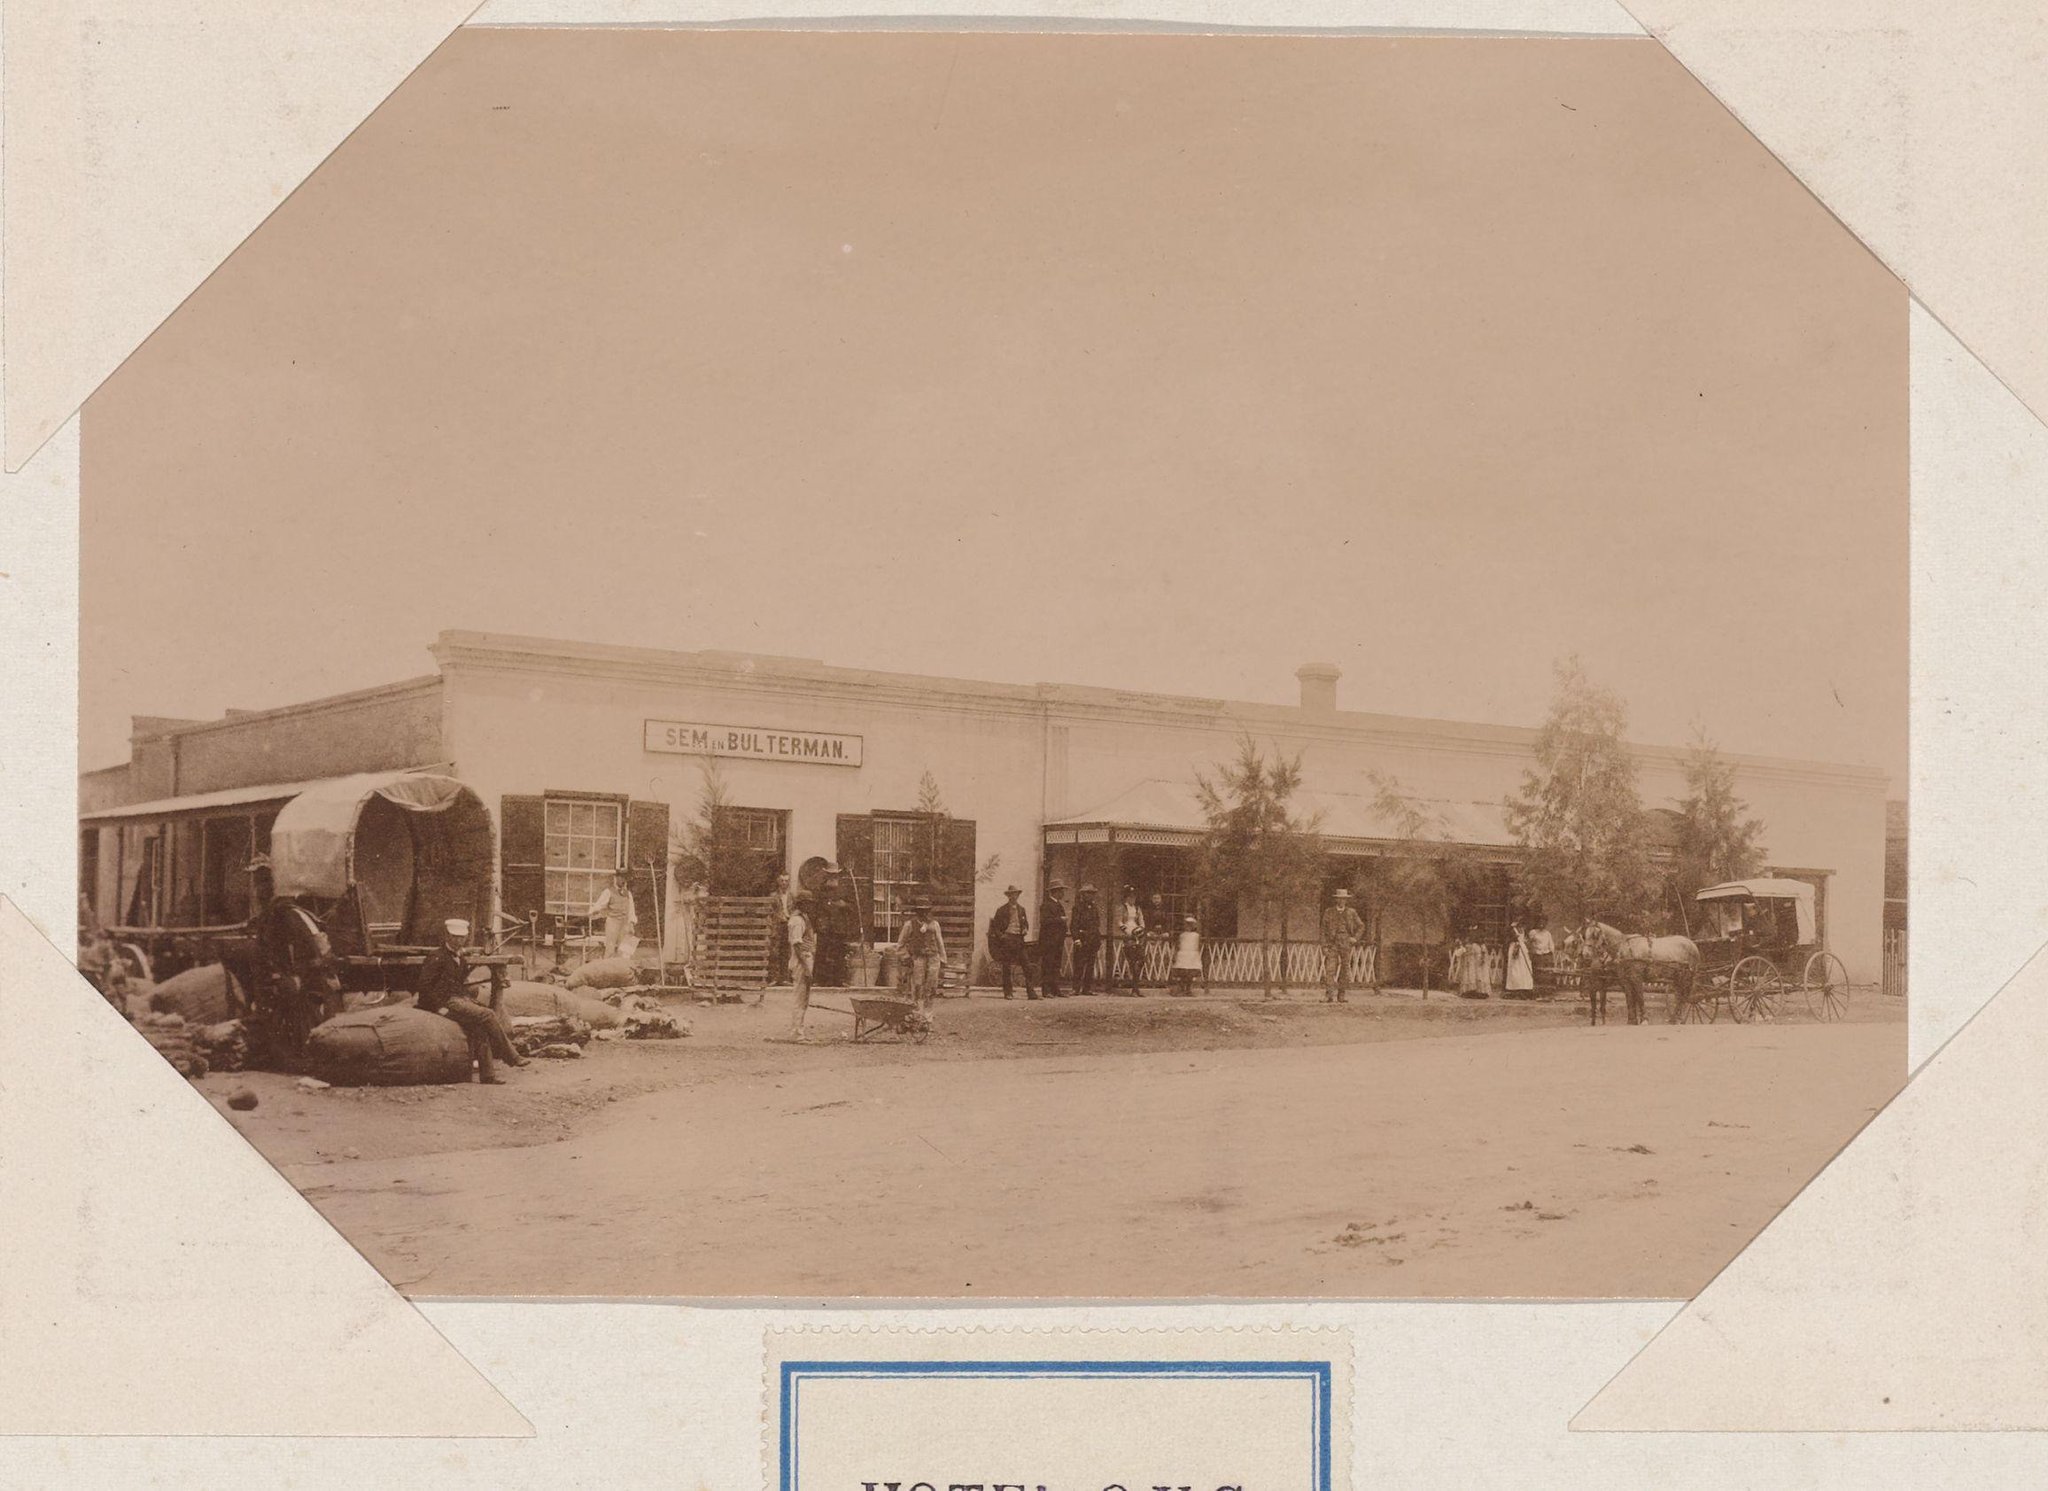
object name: photograph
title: Gebouw van Sem en Bulterman in Oranje Vrijstaat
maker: Anonymous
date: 1885-1910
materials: paper, photographic support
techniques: collodion silver print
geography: orange free state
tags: hotel, hostelry, inn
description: Onderdeel van Album met 191 foto's van een reis naar en door Zuid-Afrika.